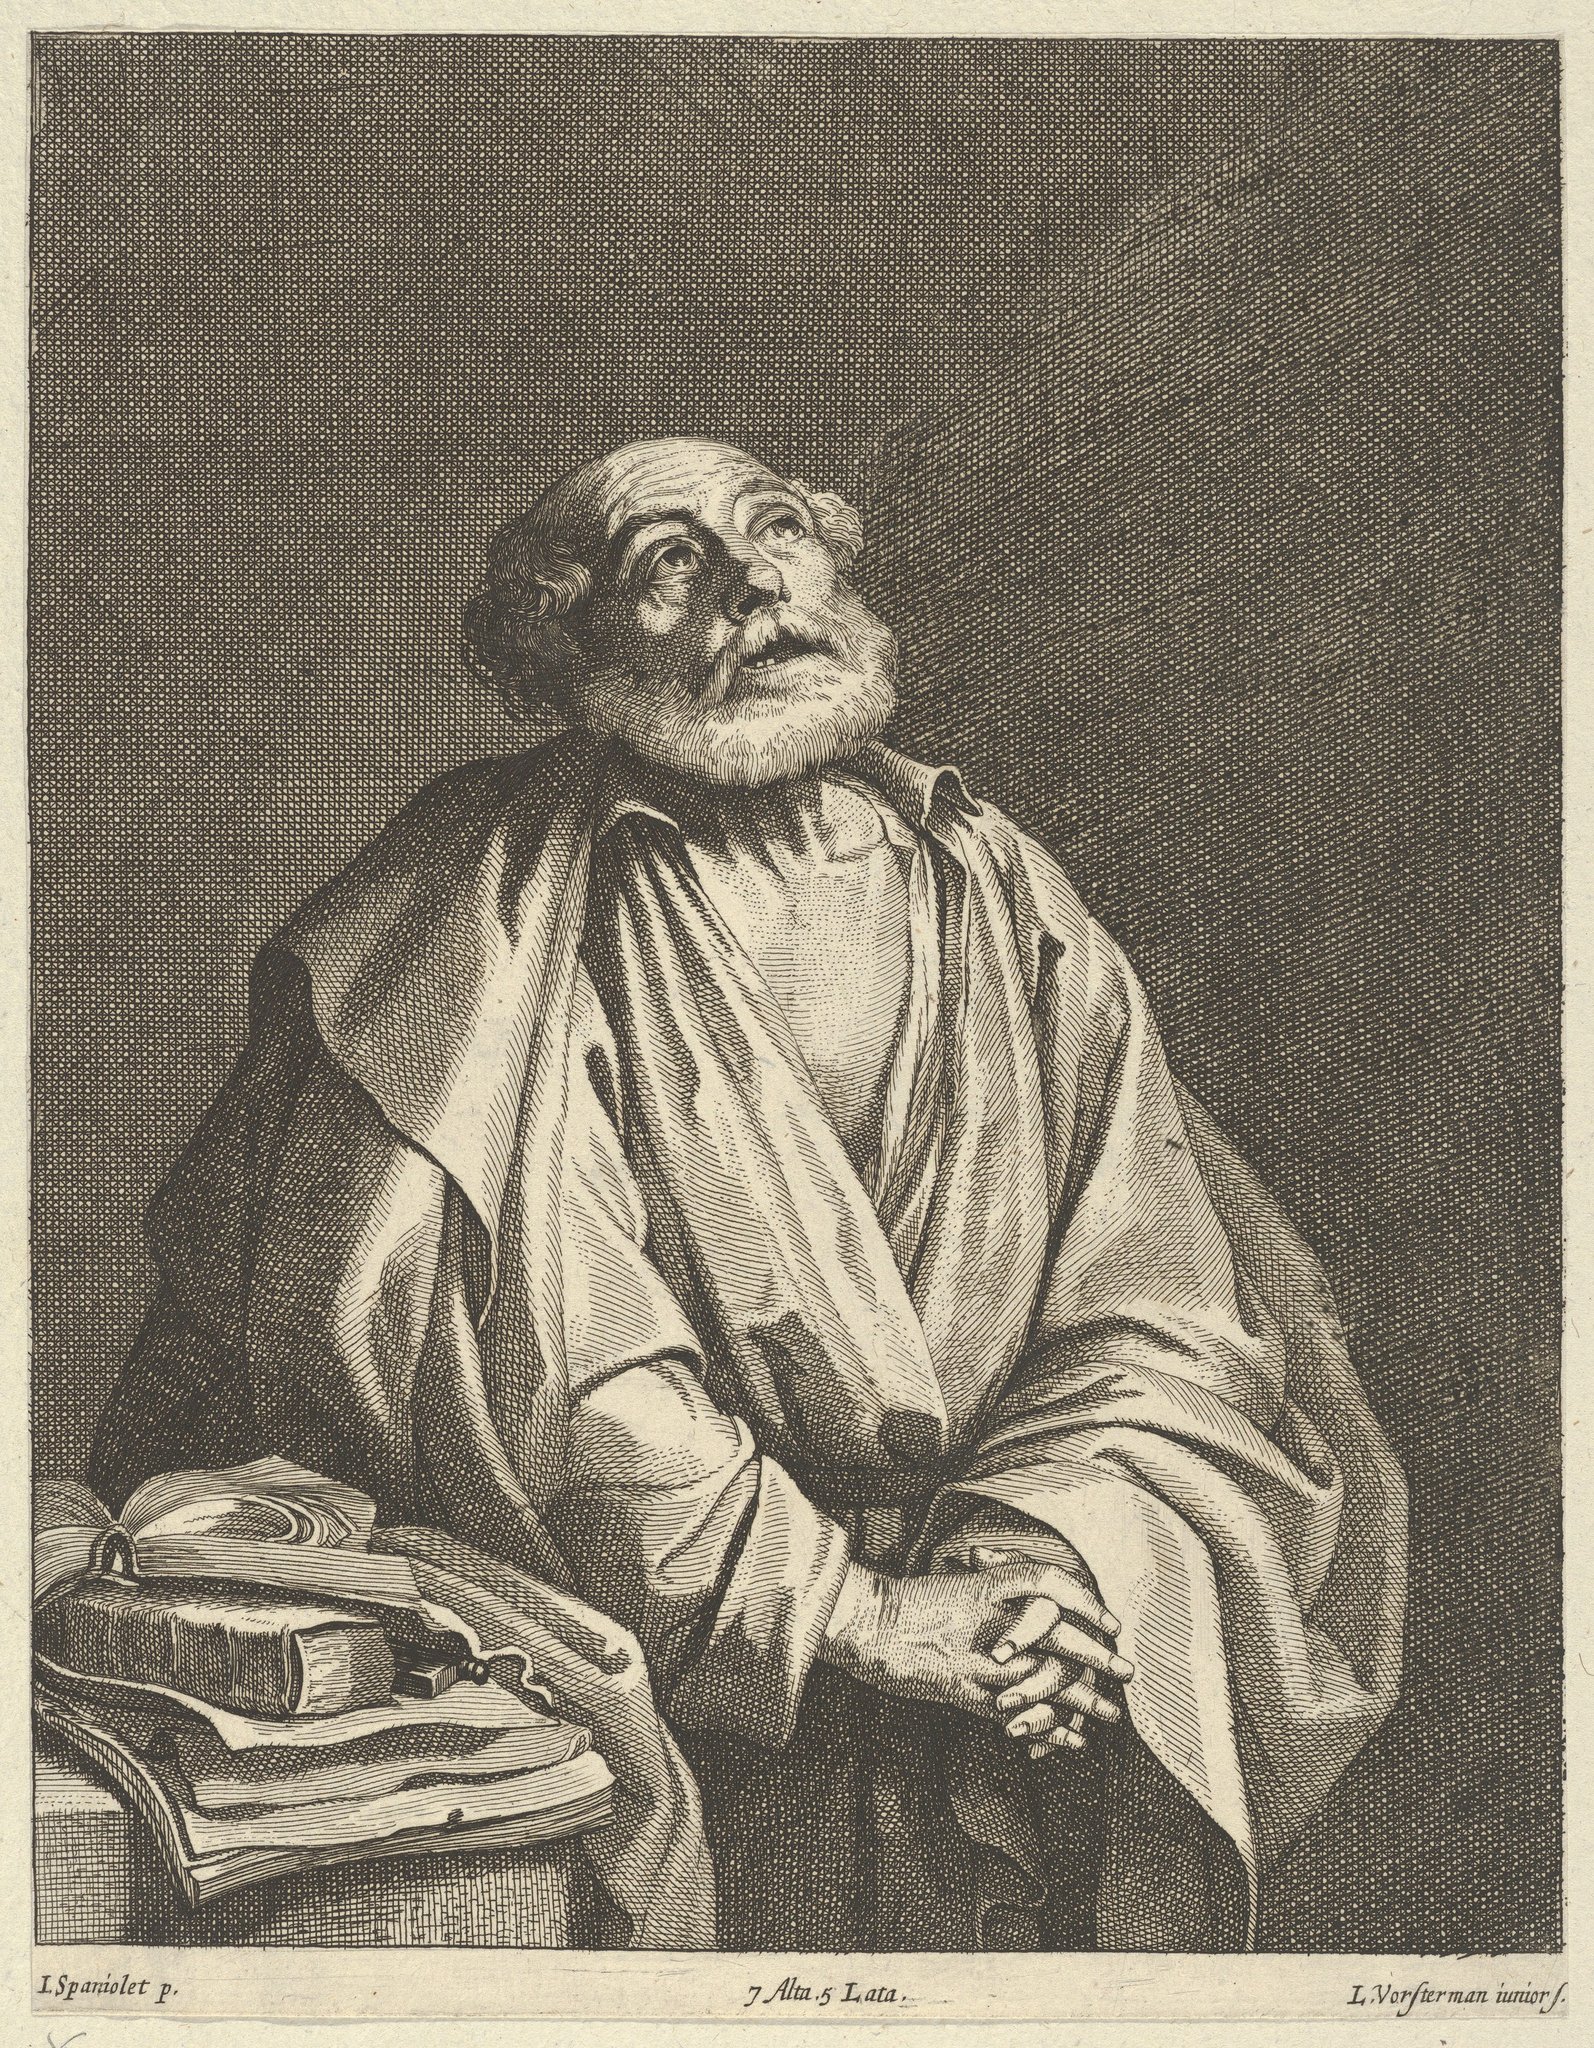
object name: print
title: Saint Peter in prayer, looking upwards and to the right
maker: lucas vorsterman (ii)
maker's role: artist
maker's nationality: flemish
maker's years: 1624-1666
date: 1656-1660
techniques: etching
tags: saint peter